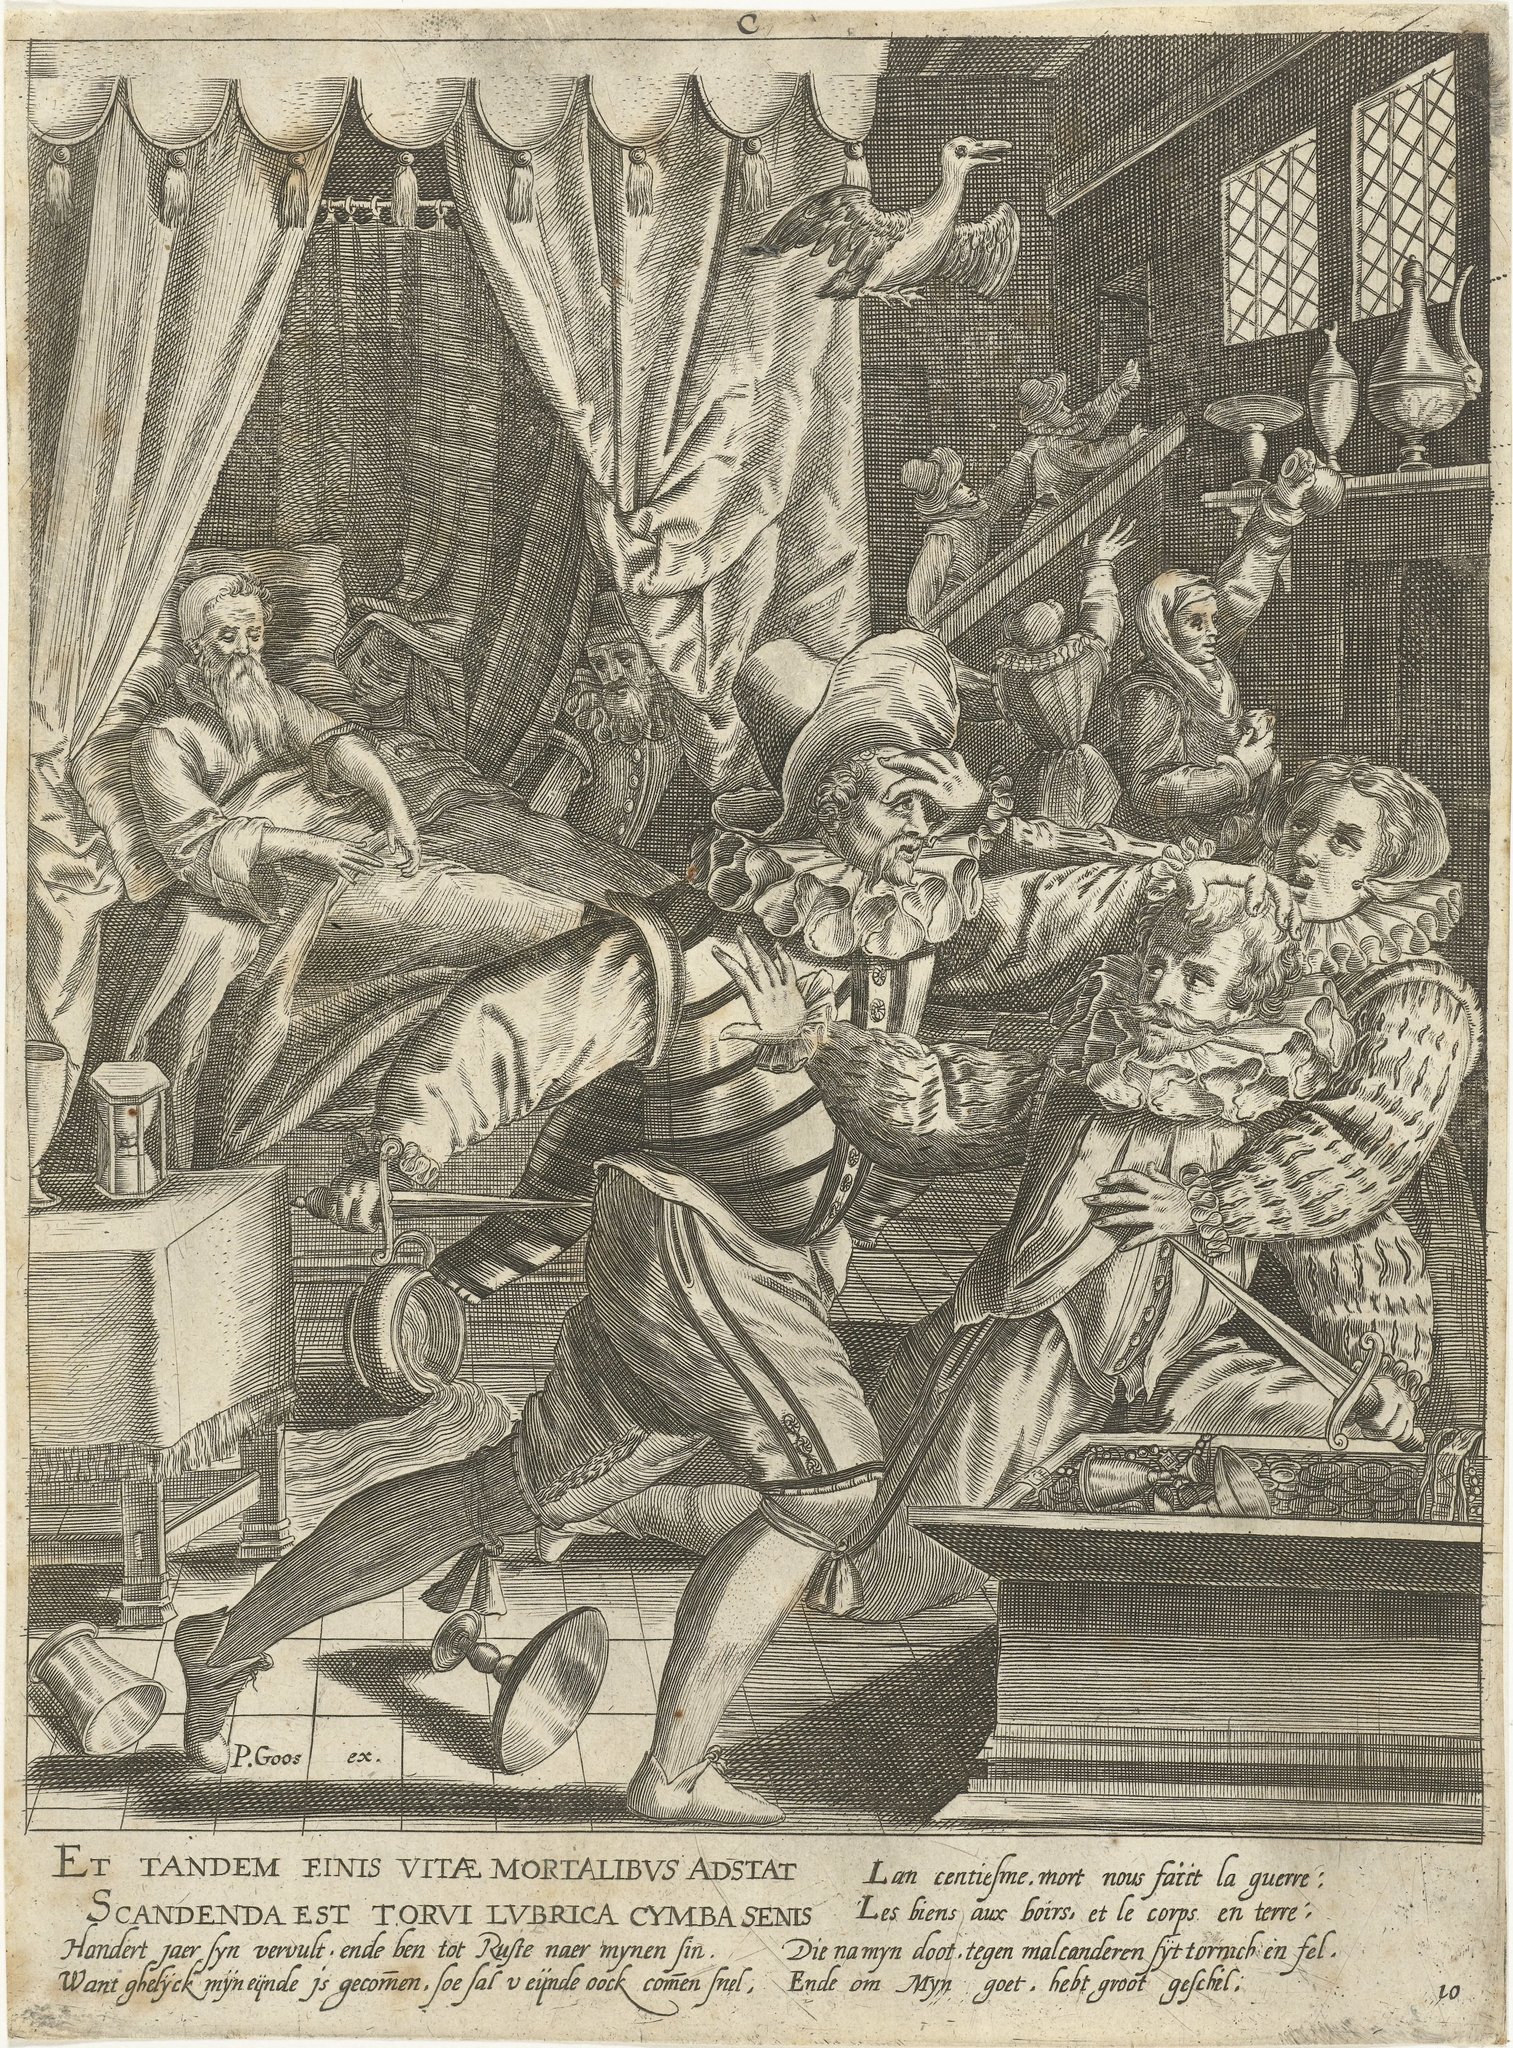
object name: print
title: Tien levensfasen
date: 1598-1602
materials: paper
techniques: engraving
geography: netherlands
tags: dying, the ages of man (+ fighting)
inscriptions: collector's mark: Lugt 2228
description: Prent naar ontwerp van Nicolaes de Bruyn. Prent uit serie van tien prenten met de tien levensfasen. Zie voor uitgebreide documentatie Janssen 2007, p. 129-174. De Hoop Scheffer beschrijft drie verschillende uitgaven, de tweede werd uitgegeven door Pieter Goos, zie De Hoop Scheffer 1996, p. 290, mogelijk betreft het hier de tweede staat.